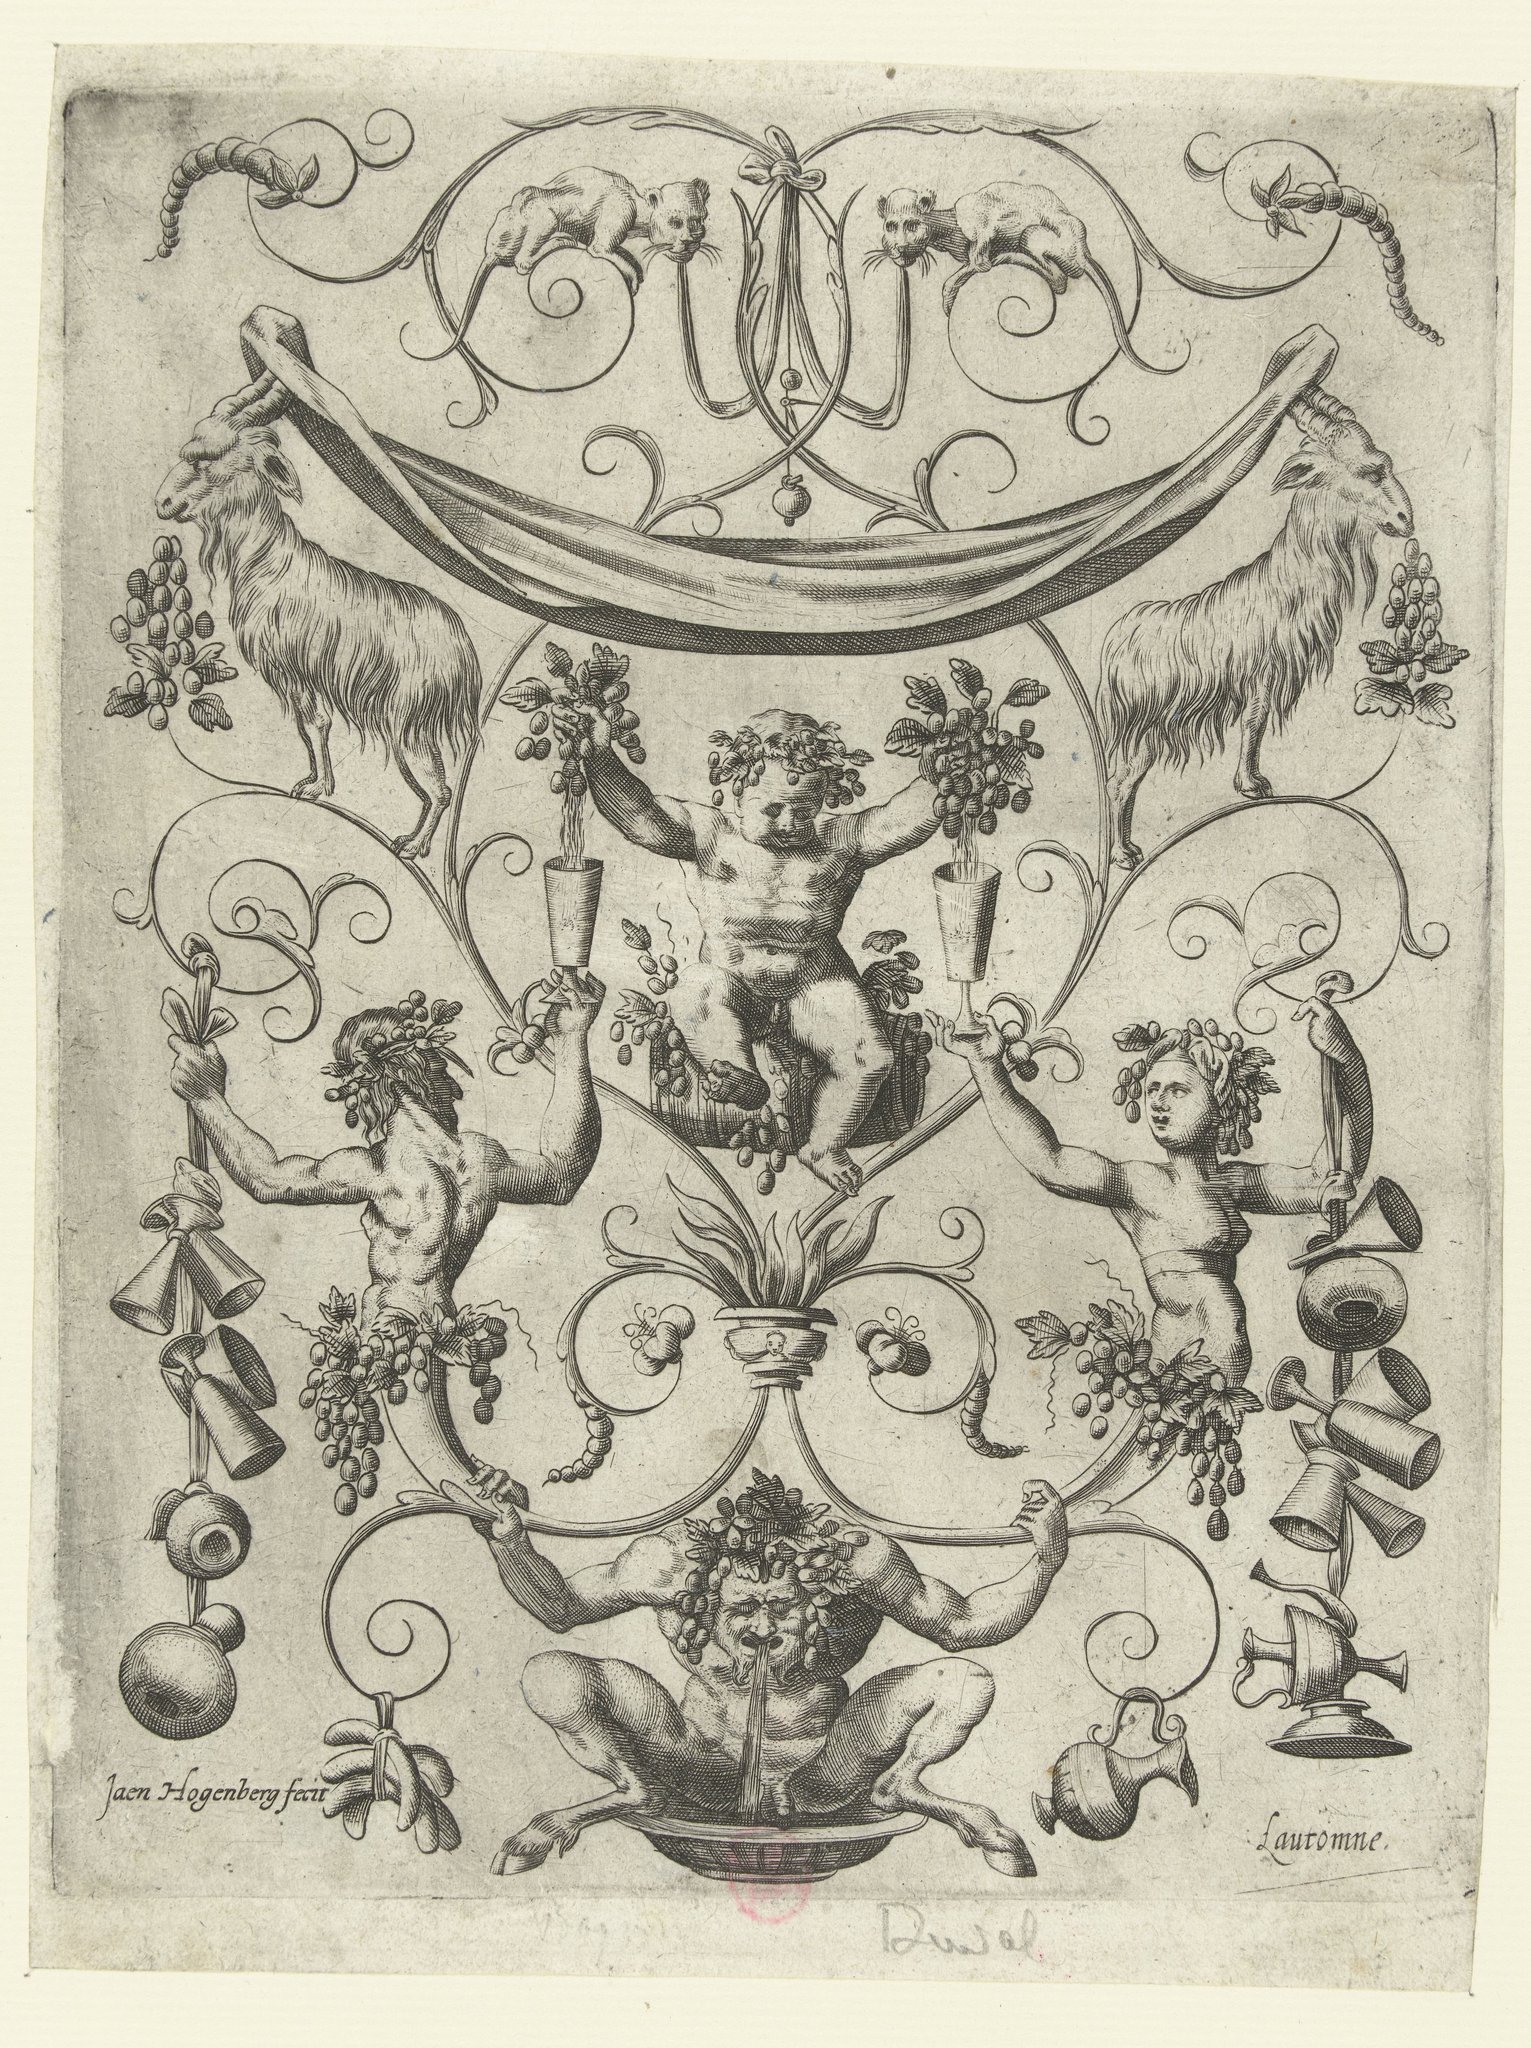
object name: print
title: Herfst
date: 1500-1600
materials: paper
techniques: engraving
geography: france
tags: autumn, fall, 'autumnus'; 'autunno' (ripa)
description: Midden onder braakt een gehurkte sater in een schaal.